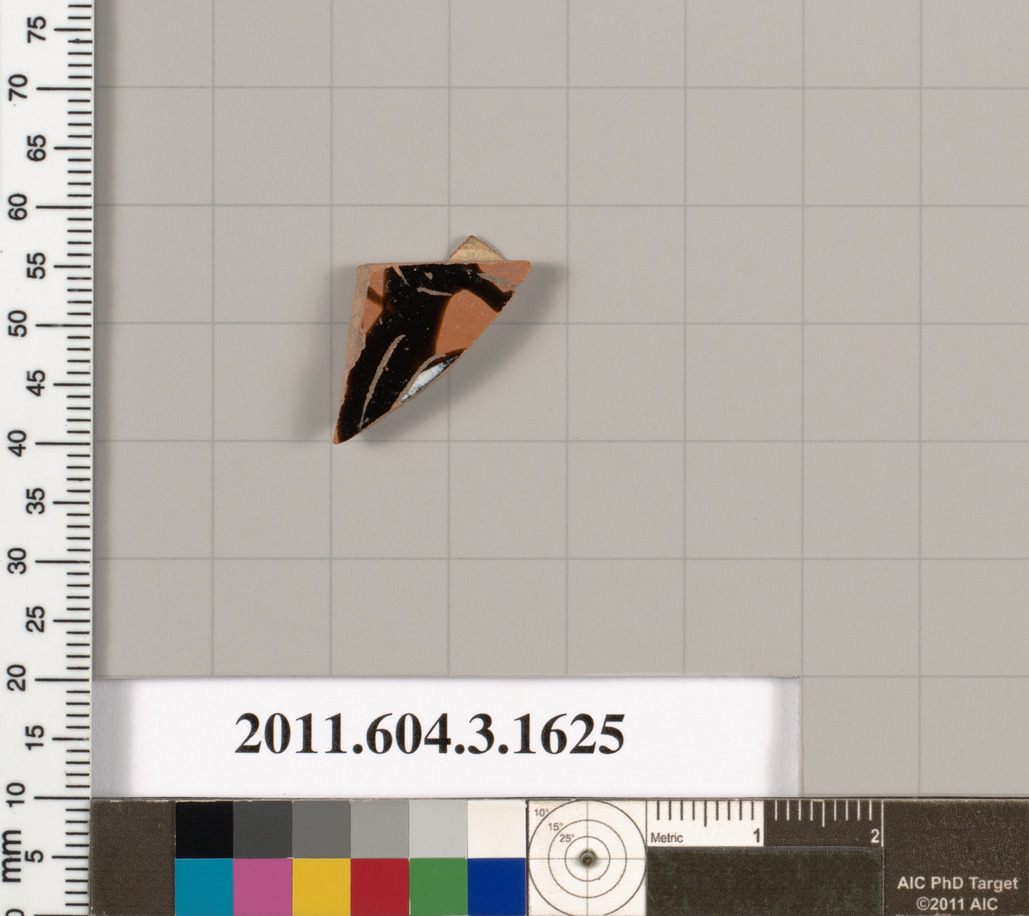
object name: kylix fragment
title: Terracotta fragment of a kylix: Band cup (drinking cup)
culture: greek, attic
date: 550-526 BCE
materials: terracotta